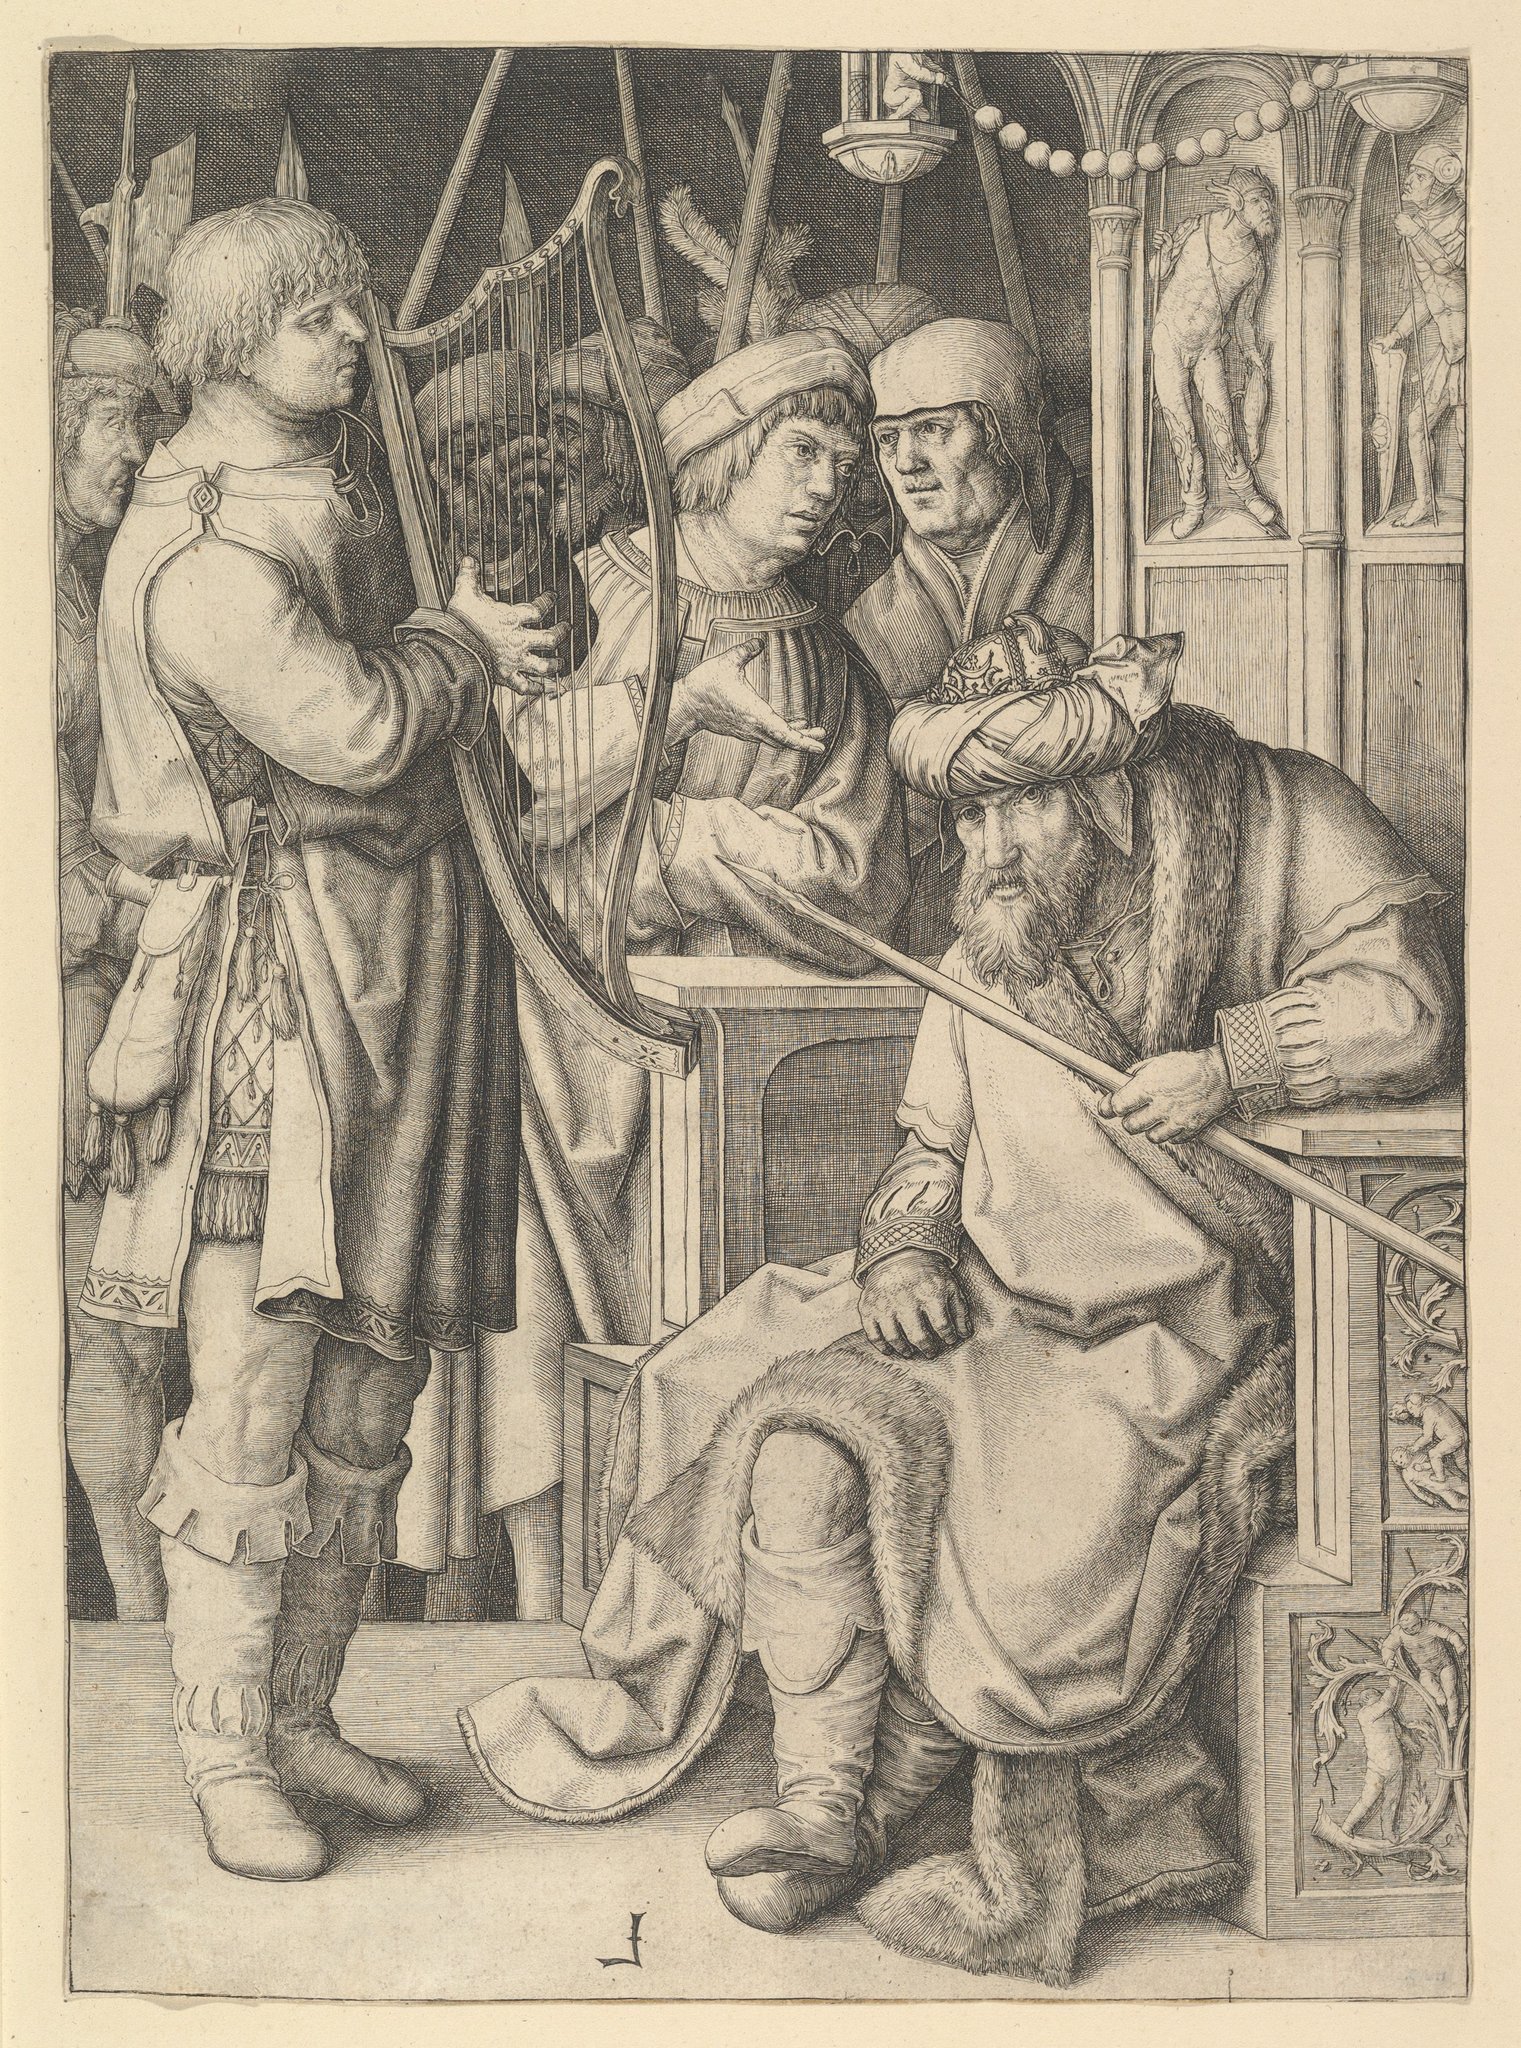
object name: print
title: David Playing the Harp Before Saul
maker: lucas van leyden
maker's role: artist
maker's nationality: netherlandish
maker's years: 1494-1533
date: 1508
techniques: engraving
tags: men,music,harps